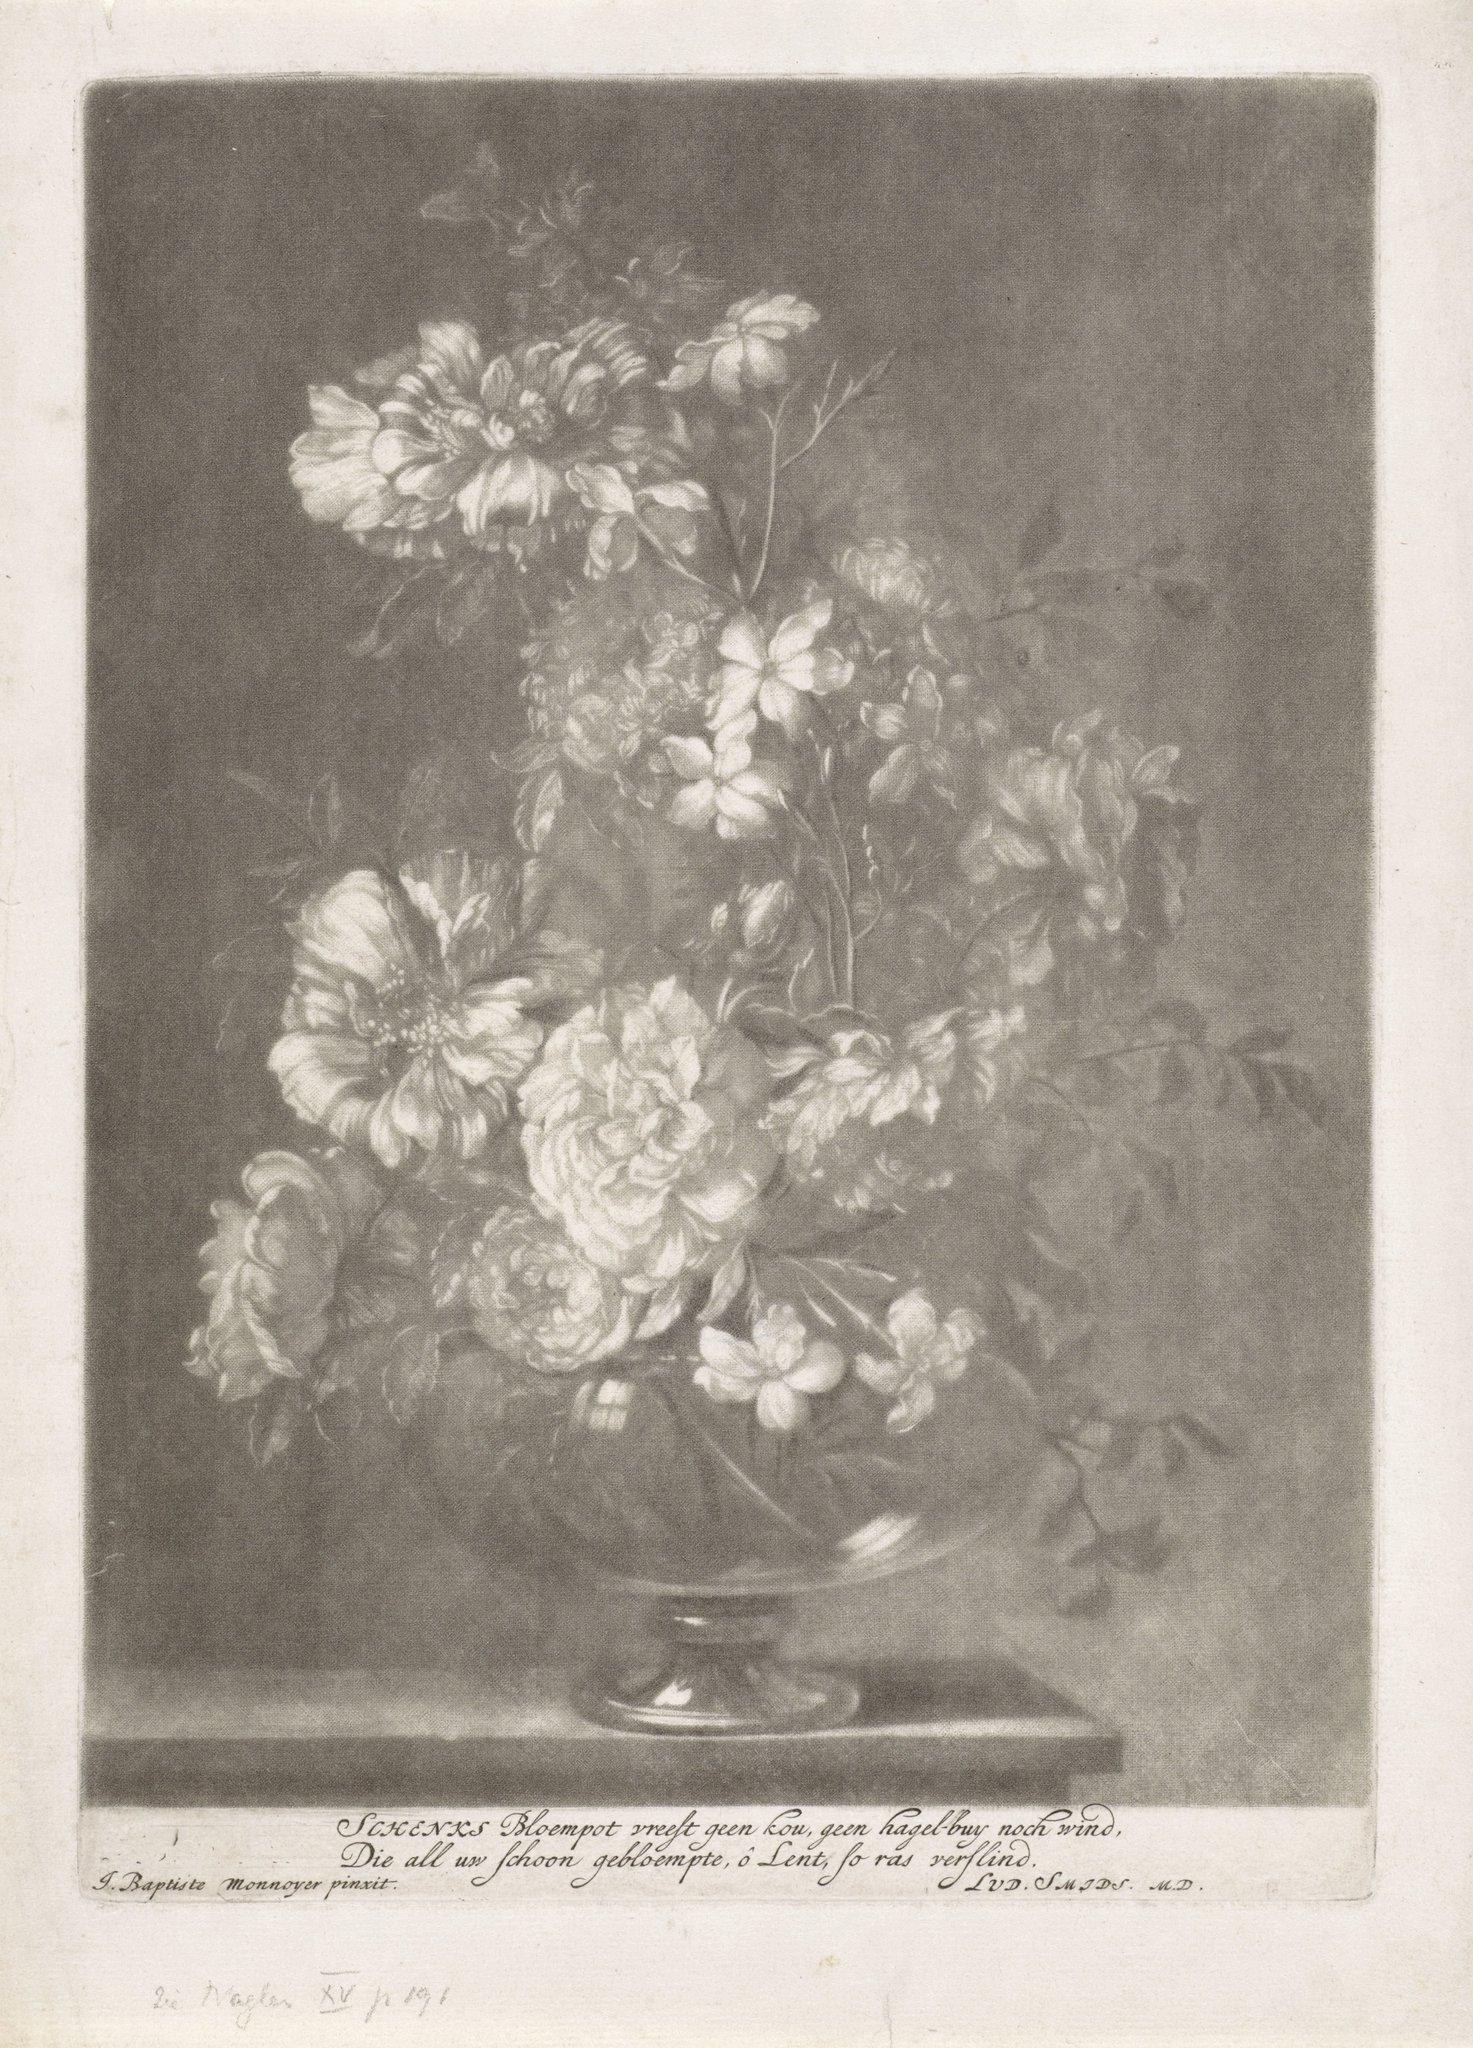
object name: print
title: Bloemen in een glazen vaas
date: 1670-1713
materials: paper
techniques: engraving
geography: amsterdam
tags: cut flowers; nosegay, bunch of flowers, container of glass: bottle, jar, vase, flowers in a vase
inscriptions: collector's mark: Lugt 2228